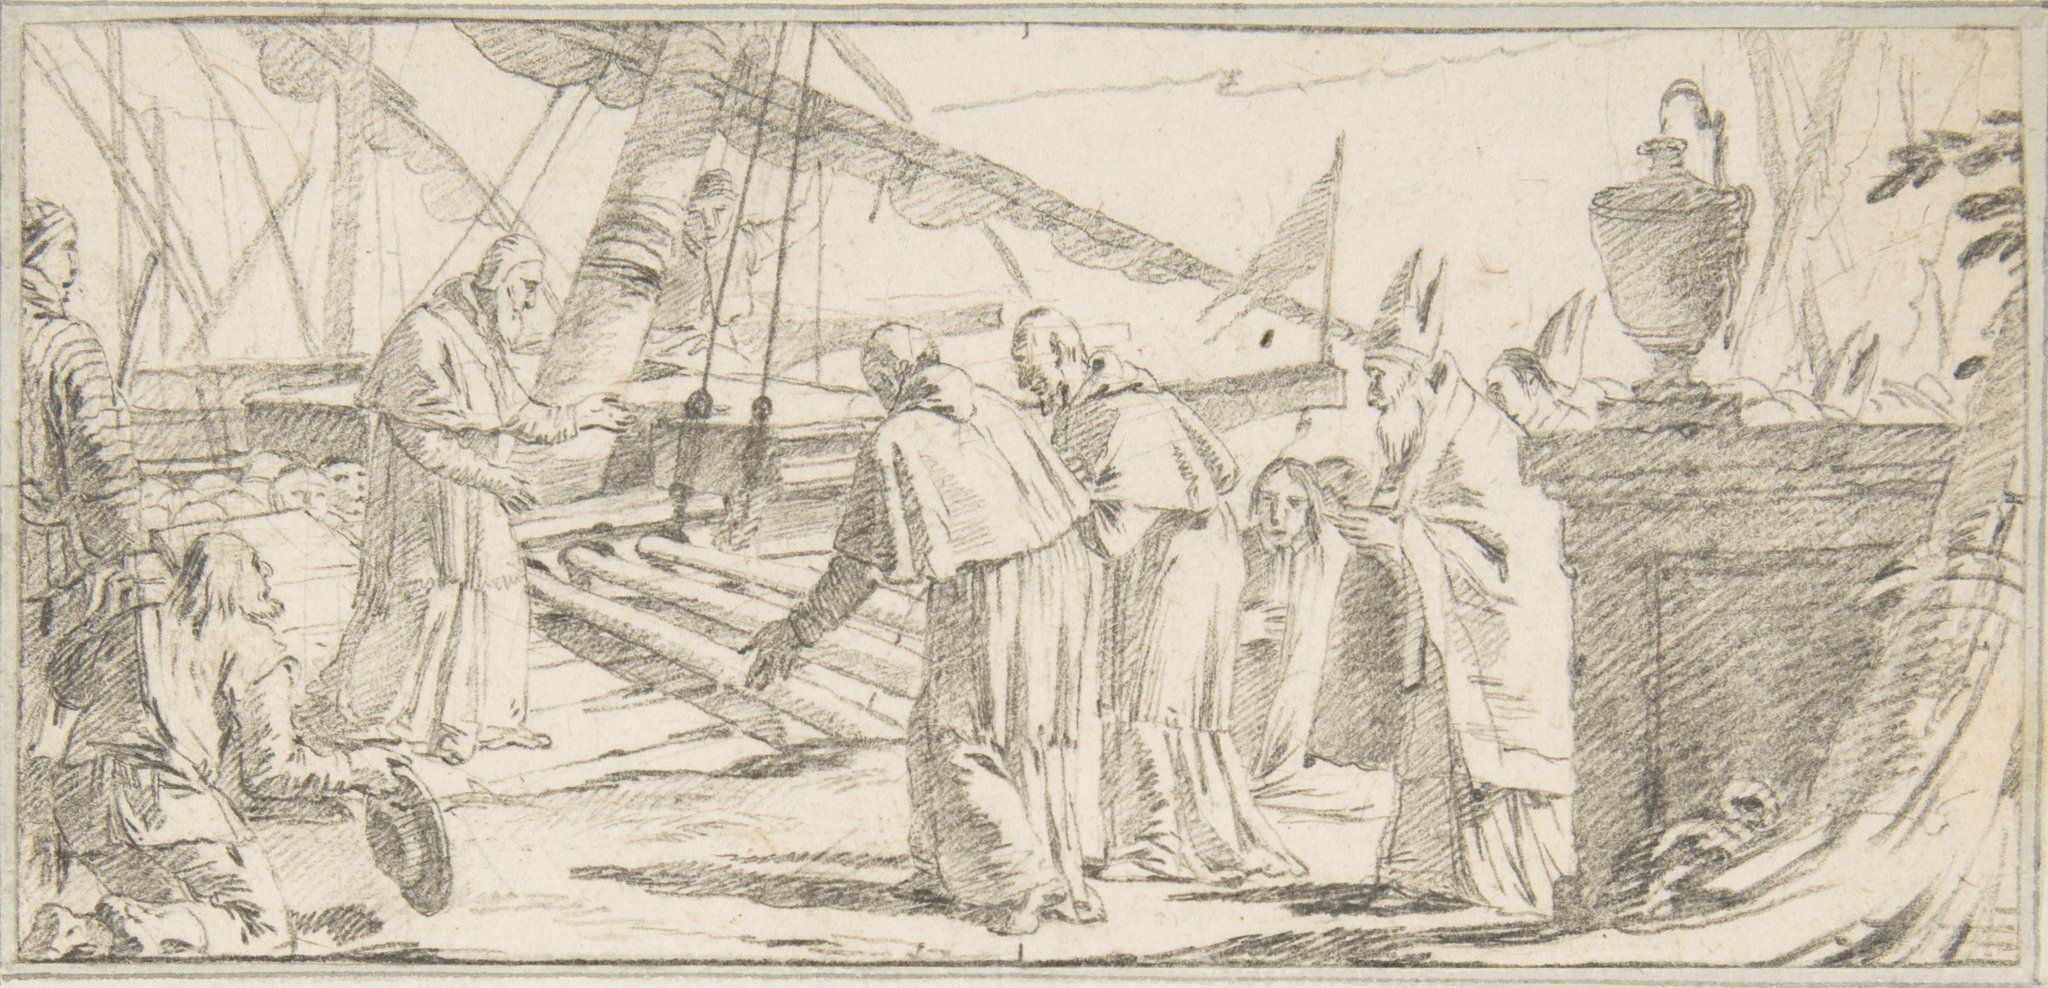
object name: drawing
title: Illustration for a Book: Bishops and Monks Being Received at a Ship by a Venerable Dignitary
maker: giovanni battista tiepolo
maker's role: artist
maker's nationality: italian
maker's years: 1696-1770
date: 1696-1770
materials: chalk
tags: bishops,monks,ships